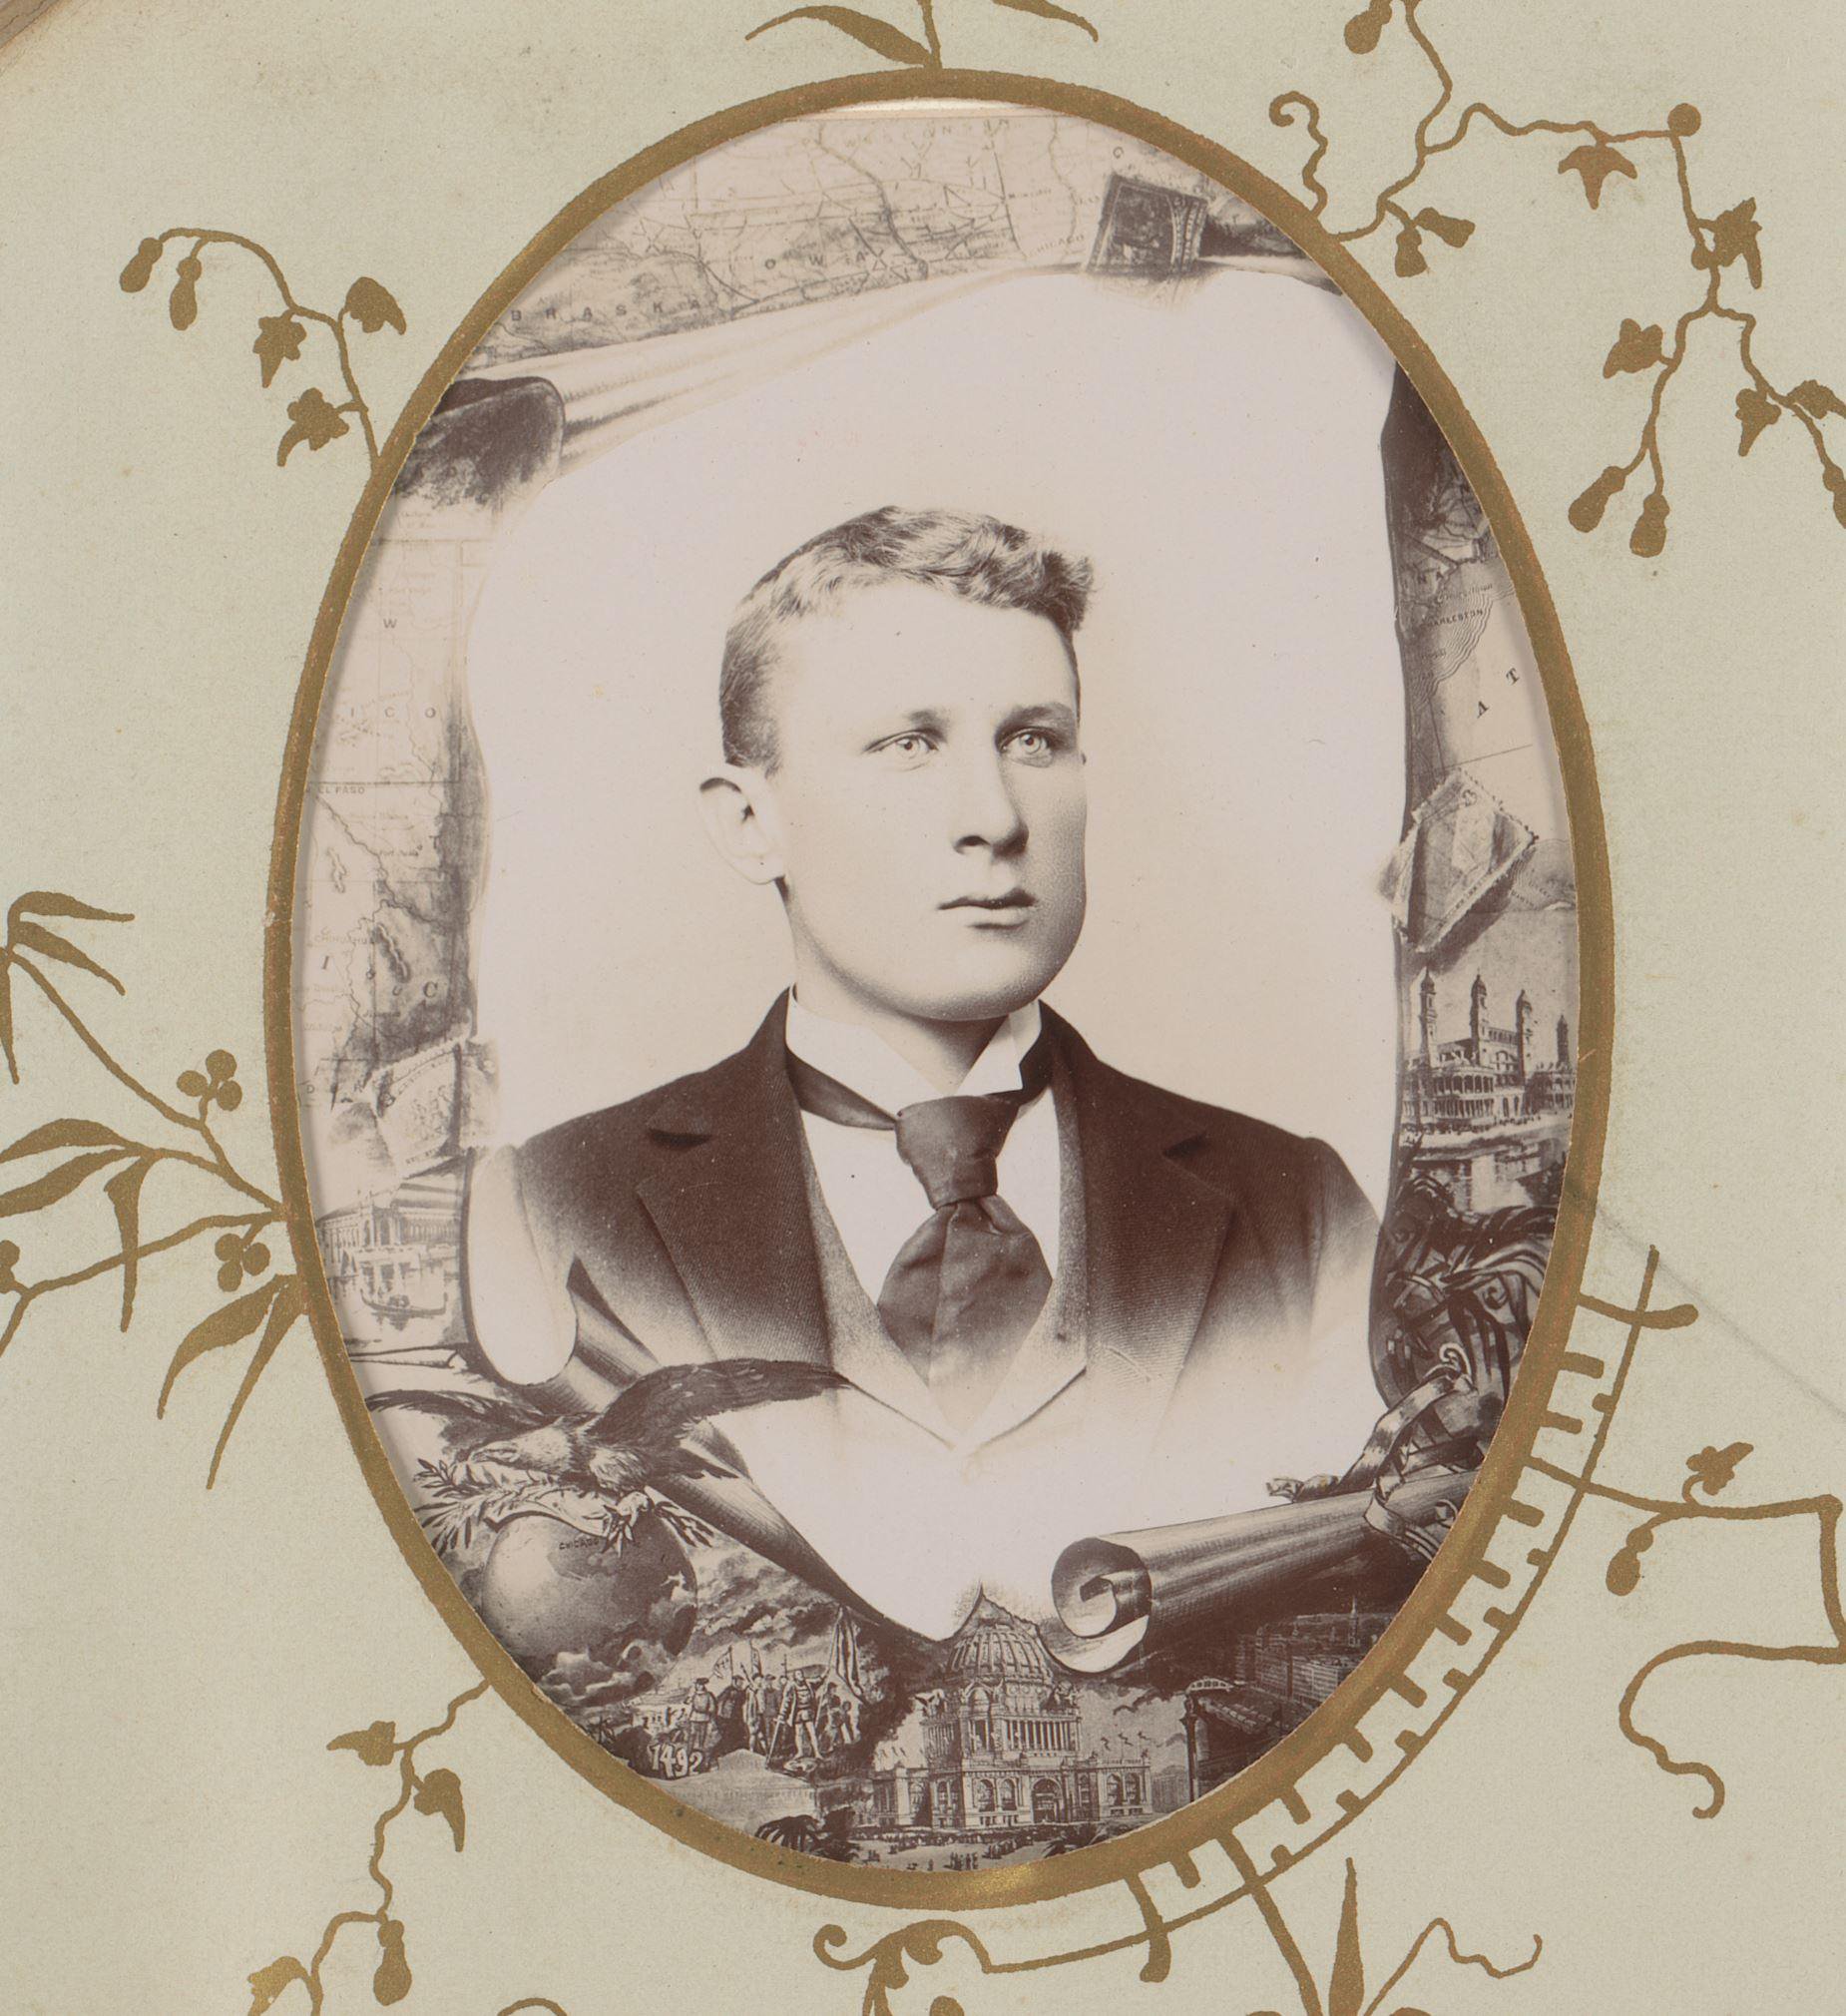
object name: album leaf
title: Portret van een man met gedecoreerde omlijsting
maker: hoffmeister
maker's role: fotograaf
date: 1860-1900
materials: cardboard, photographic support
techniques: collodion silver print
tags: adult man, 'passe-partout', historical persons